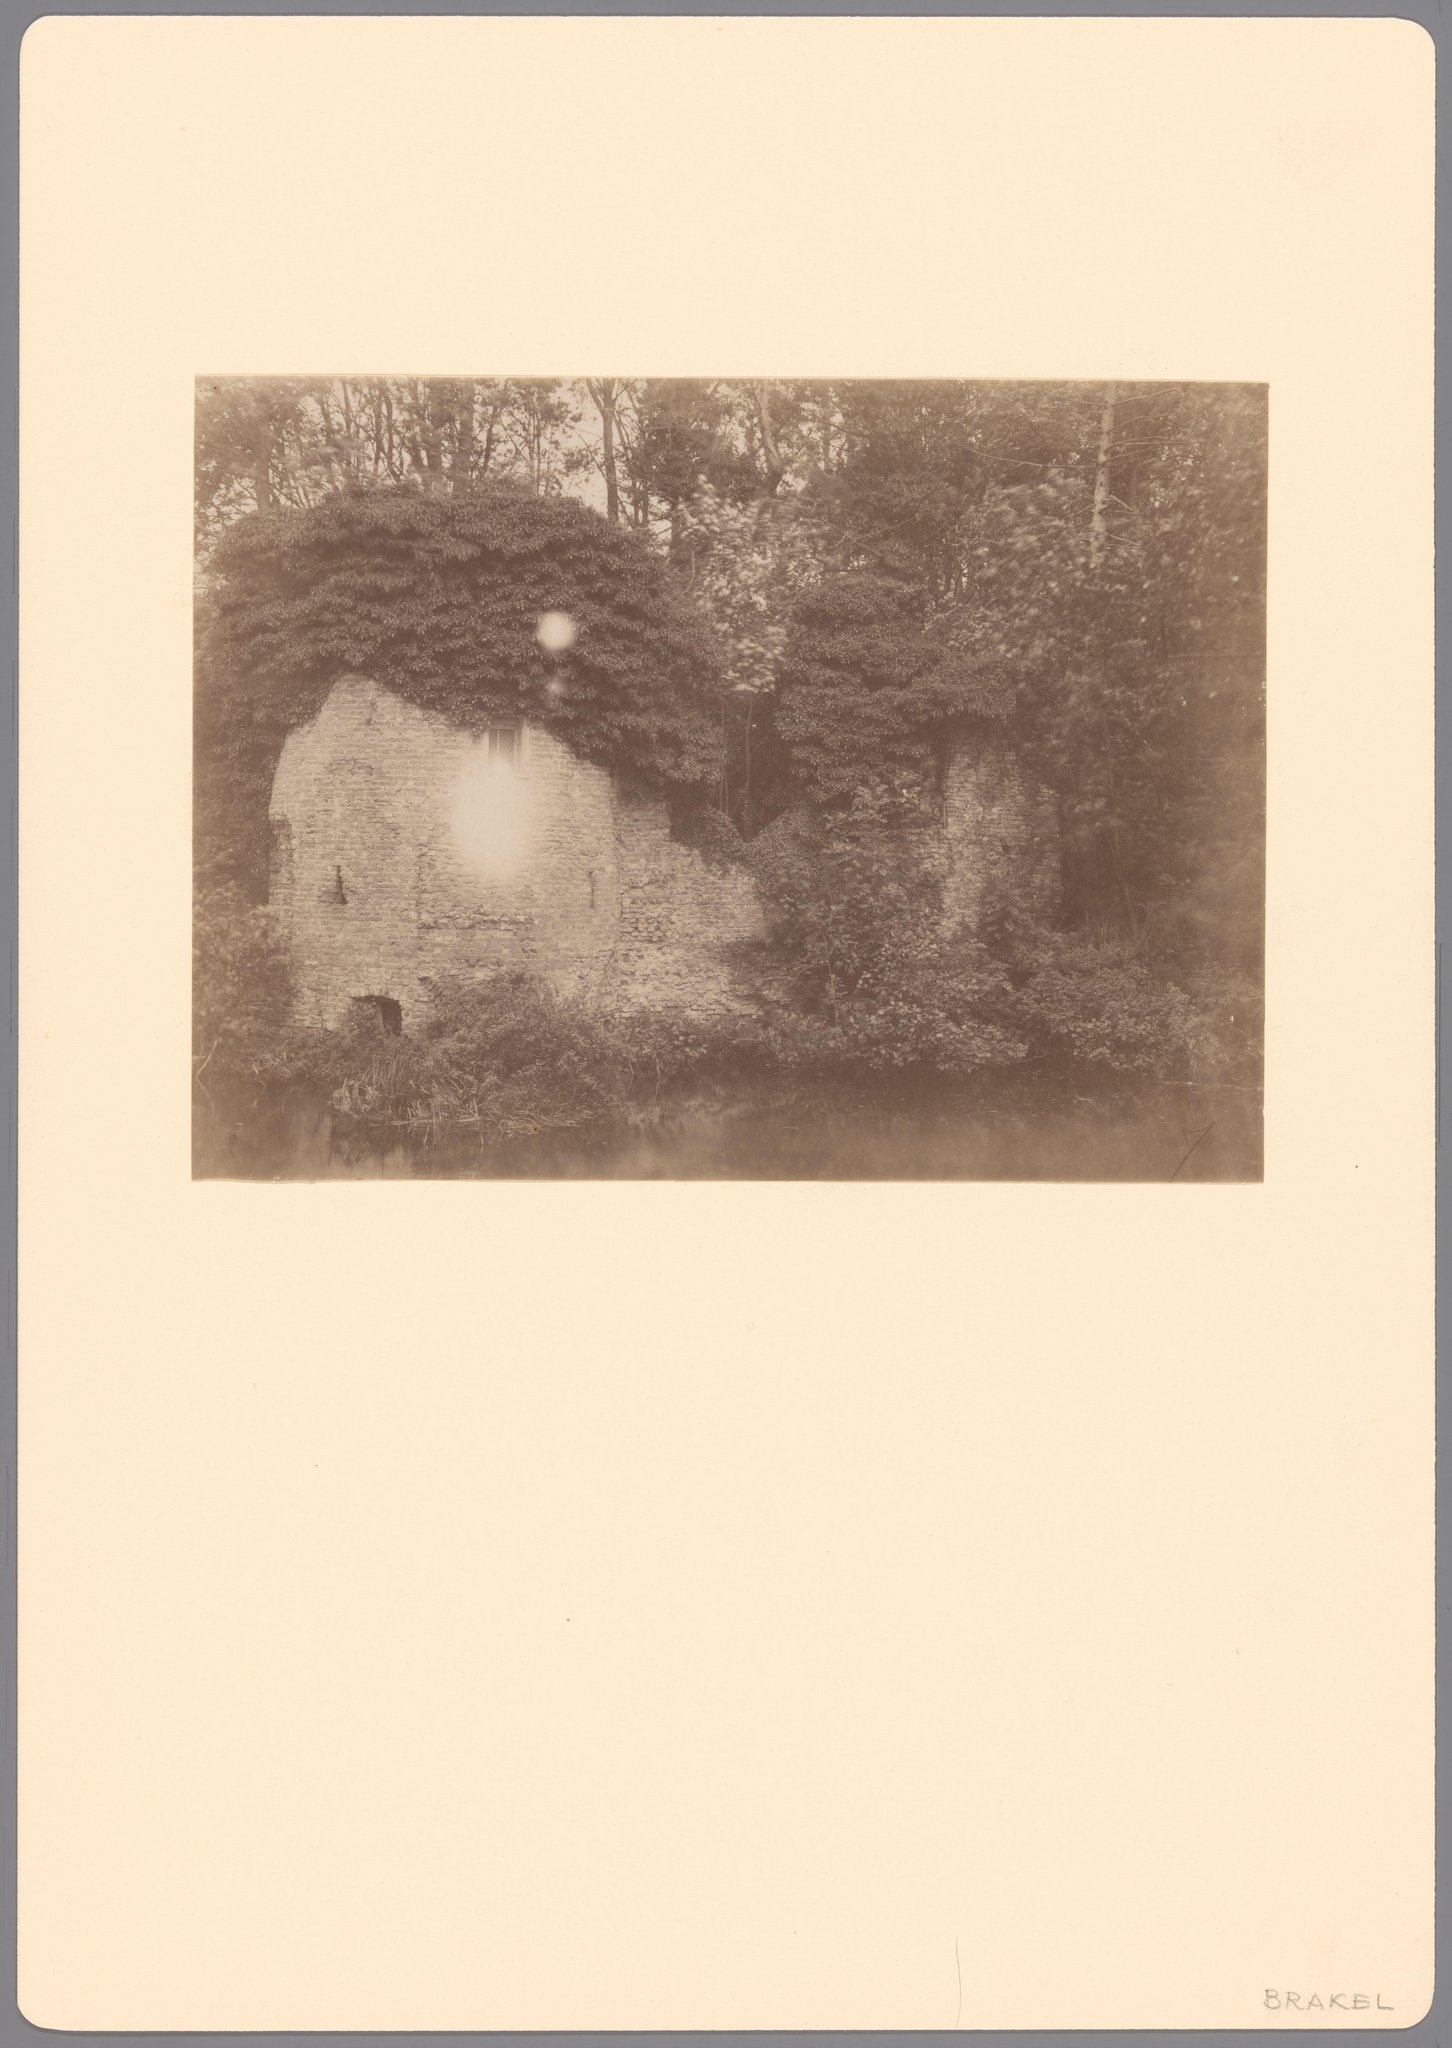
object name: photograph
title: Ruïne van Kasteel Brakel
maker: anoniem (monumentenzorg)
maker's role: fotograaf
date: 1930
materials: cardboard, photographic support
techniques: albumen print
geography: brakel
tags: ruin of a dwelling, house, castle, etc.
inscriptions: annotation: ‘Brakel’, annotation: ‘Overblijfsel van het huis ter Brakel’